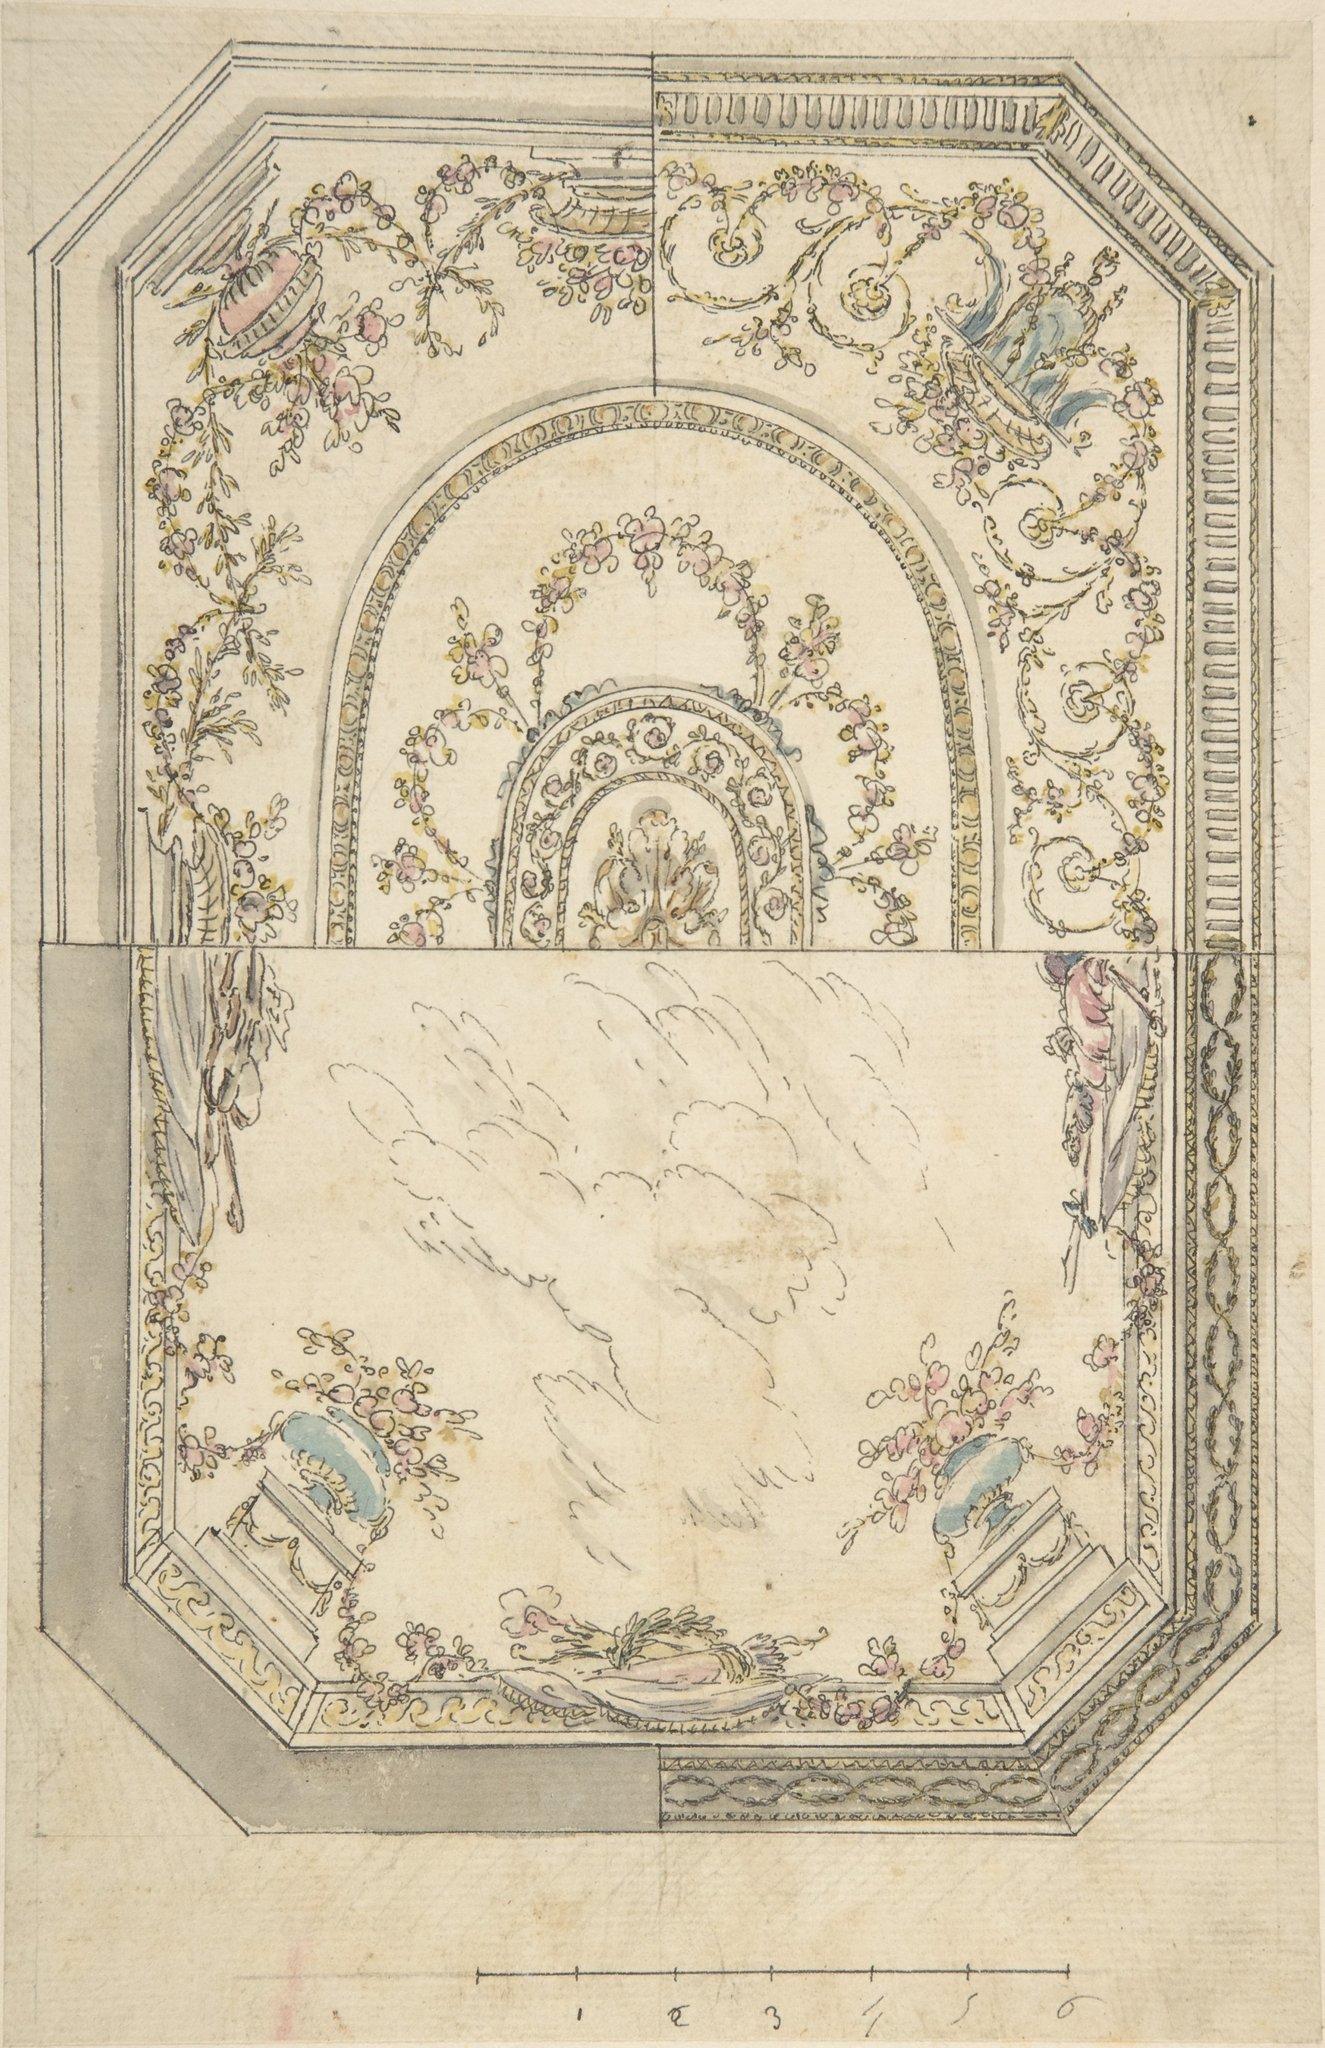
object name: drawing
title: Au Choix Design for a Ceiling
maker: anonymous, italian, 18th century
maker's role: artist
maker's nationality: italian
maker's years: 1700-1800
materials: graphite, ink, watercolor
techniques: brush, drawing, pen, wash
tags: leaves